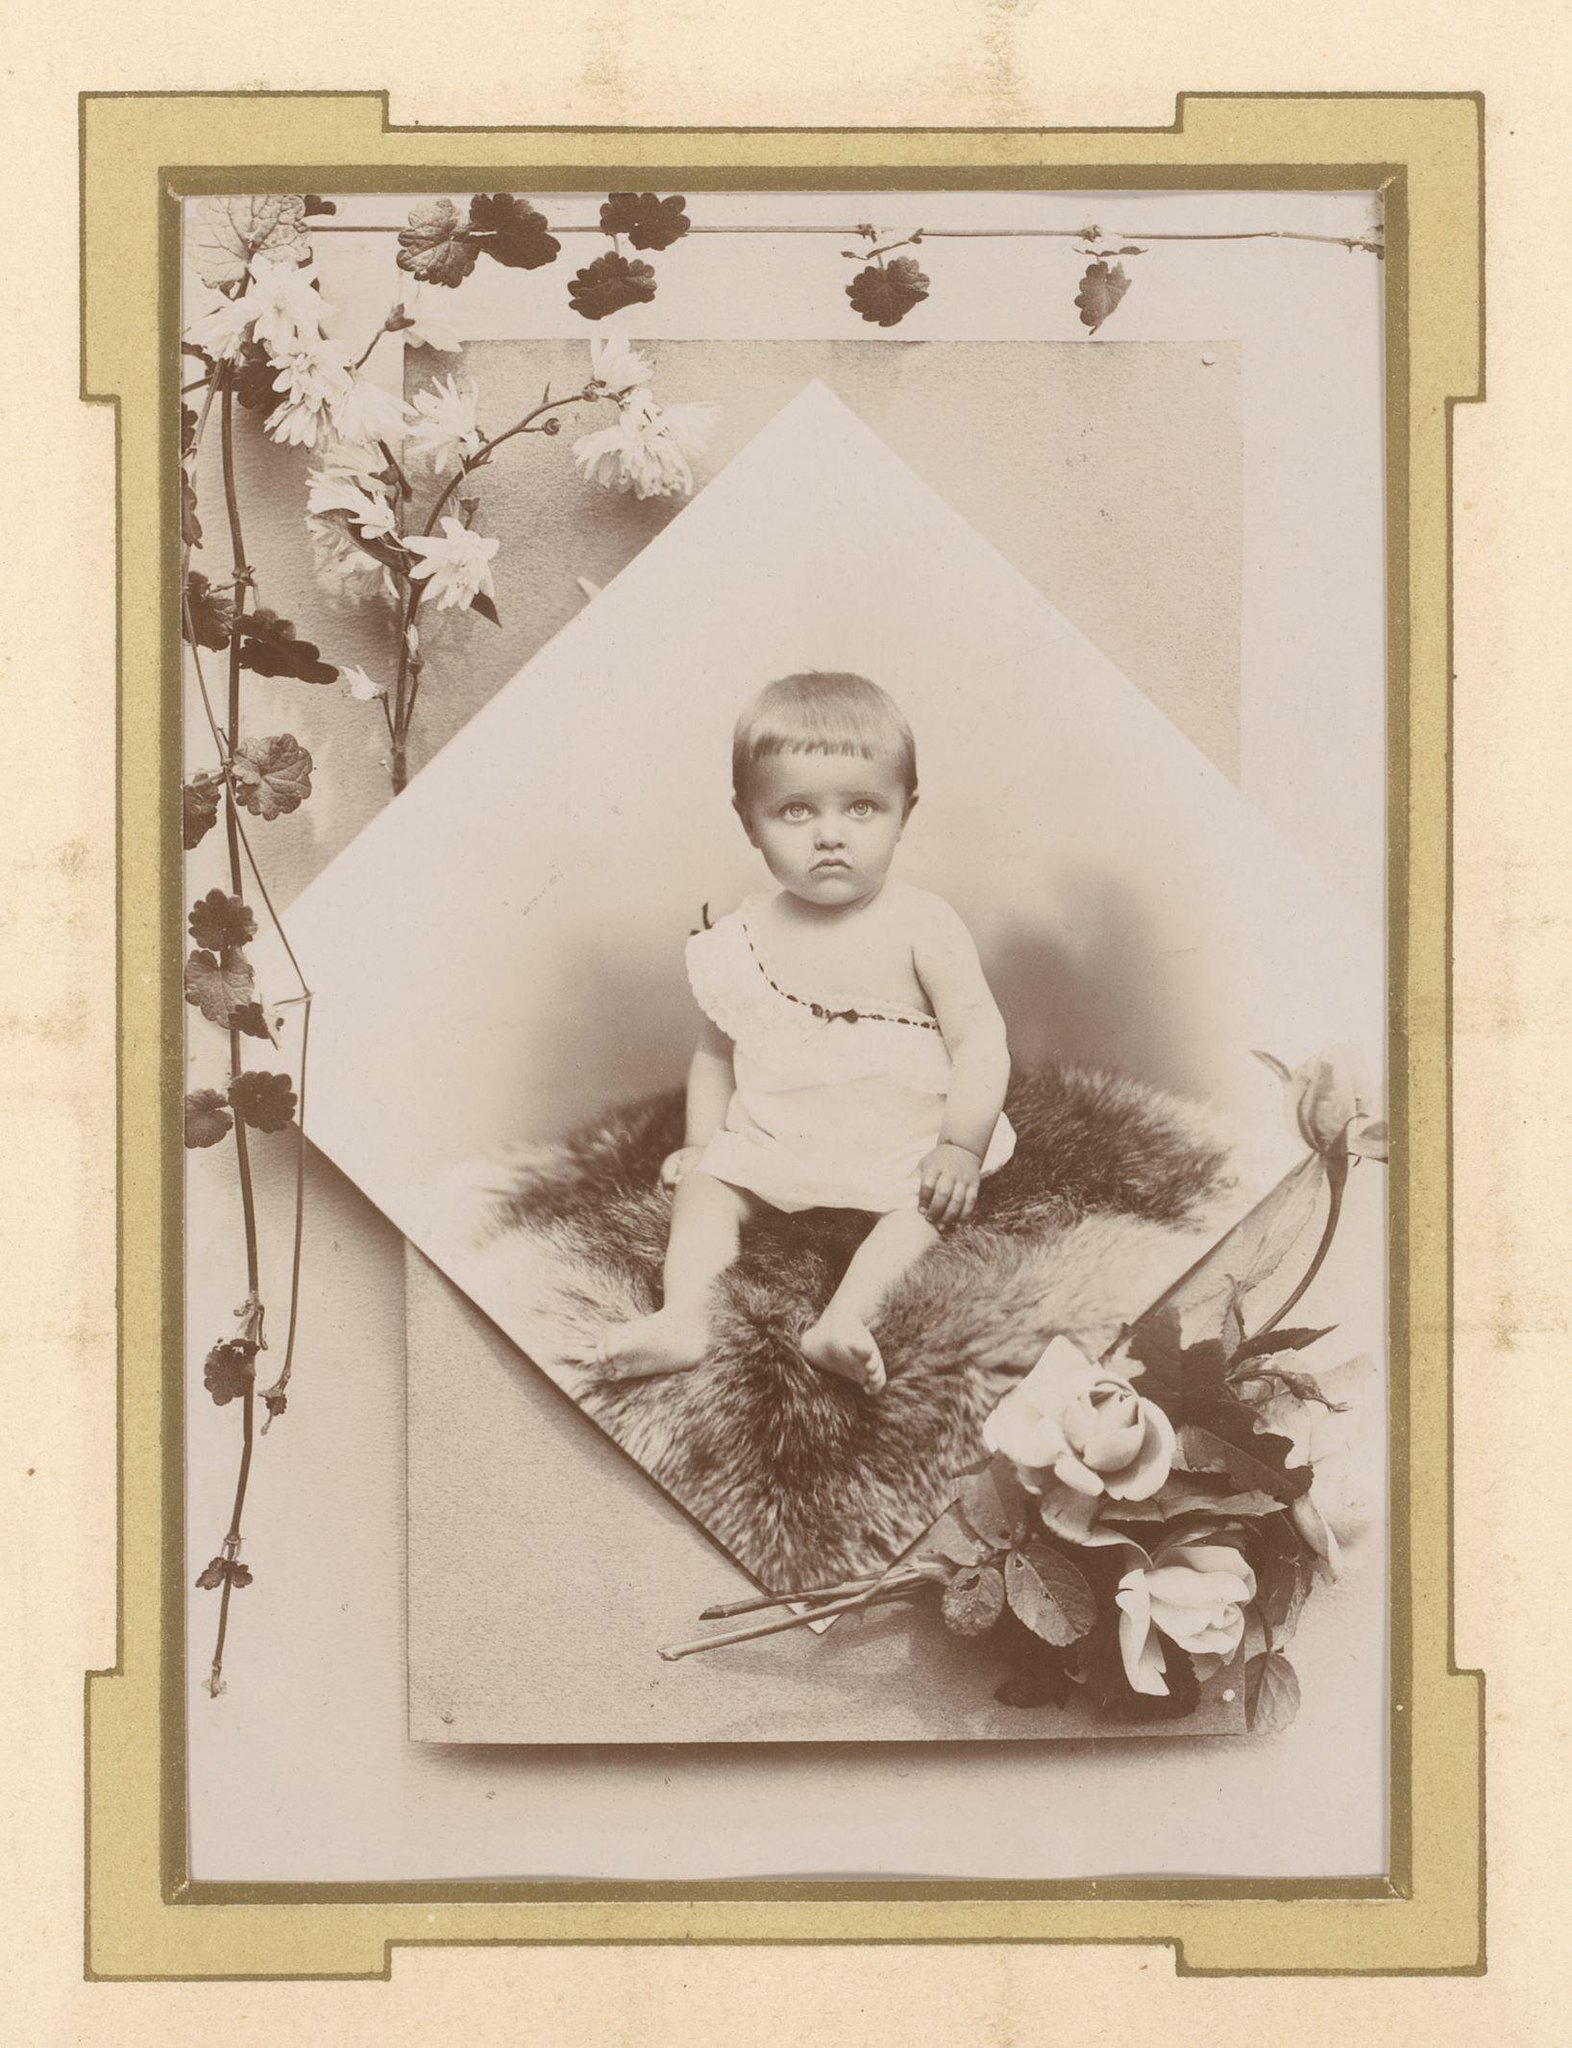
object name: album leaf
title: Portret van Roger van Hoecke met bloemen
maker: léonard tronchet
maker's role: fotograaf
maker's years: 1855-1925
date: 1880-1920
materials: cardboard, photographic support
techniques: gelatin silver print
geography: lyon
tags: boy (child between toddler and youth)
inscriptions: inscription: ‘Photographie/ L. Tronchet/ Lyon/ 6, Rue Servient’, annotation: ‘Roger van Hoecke/ 9 mois’